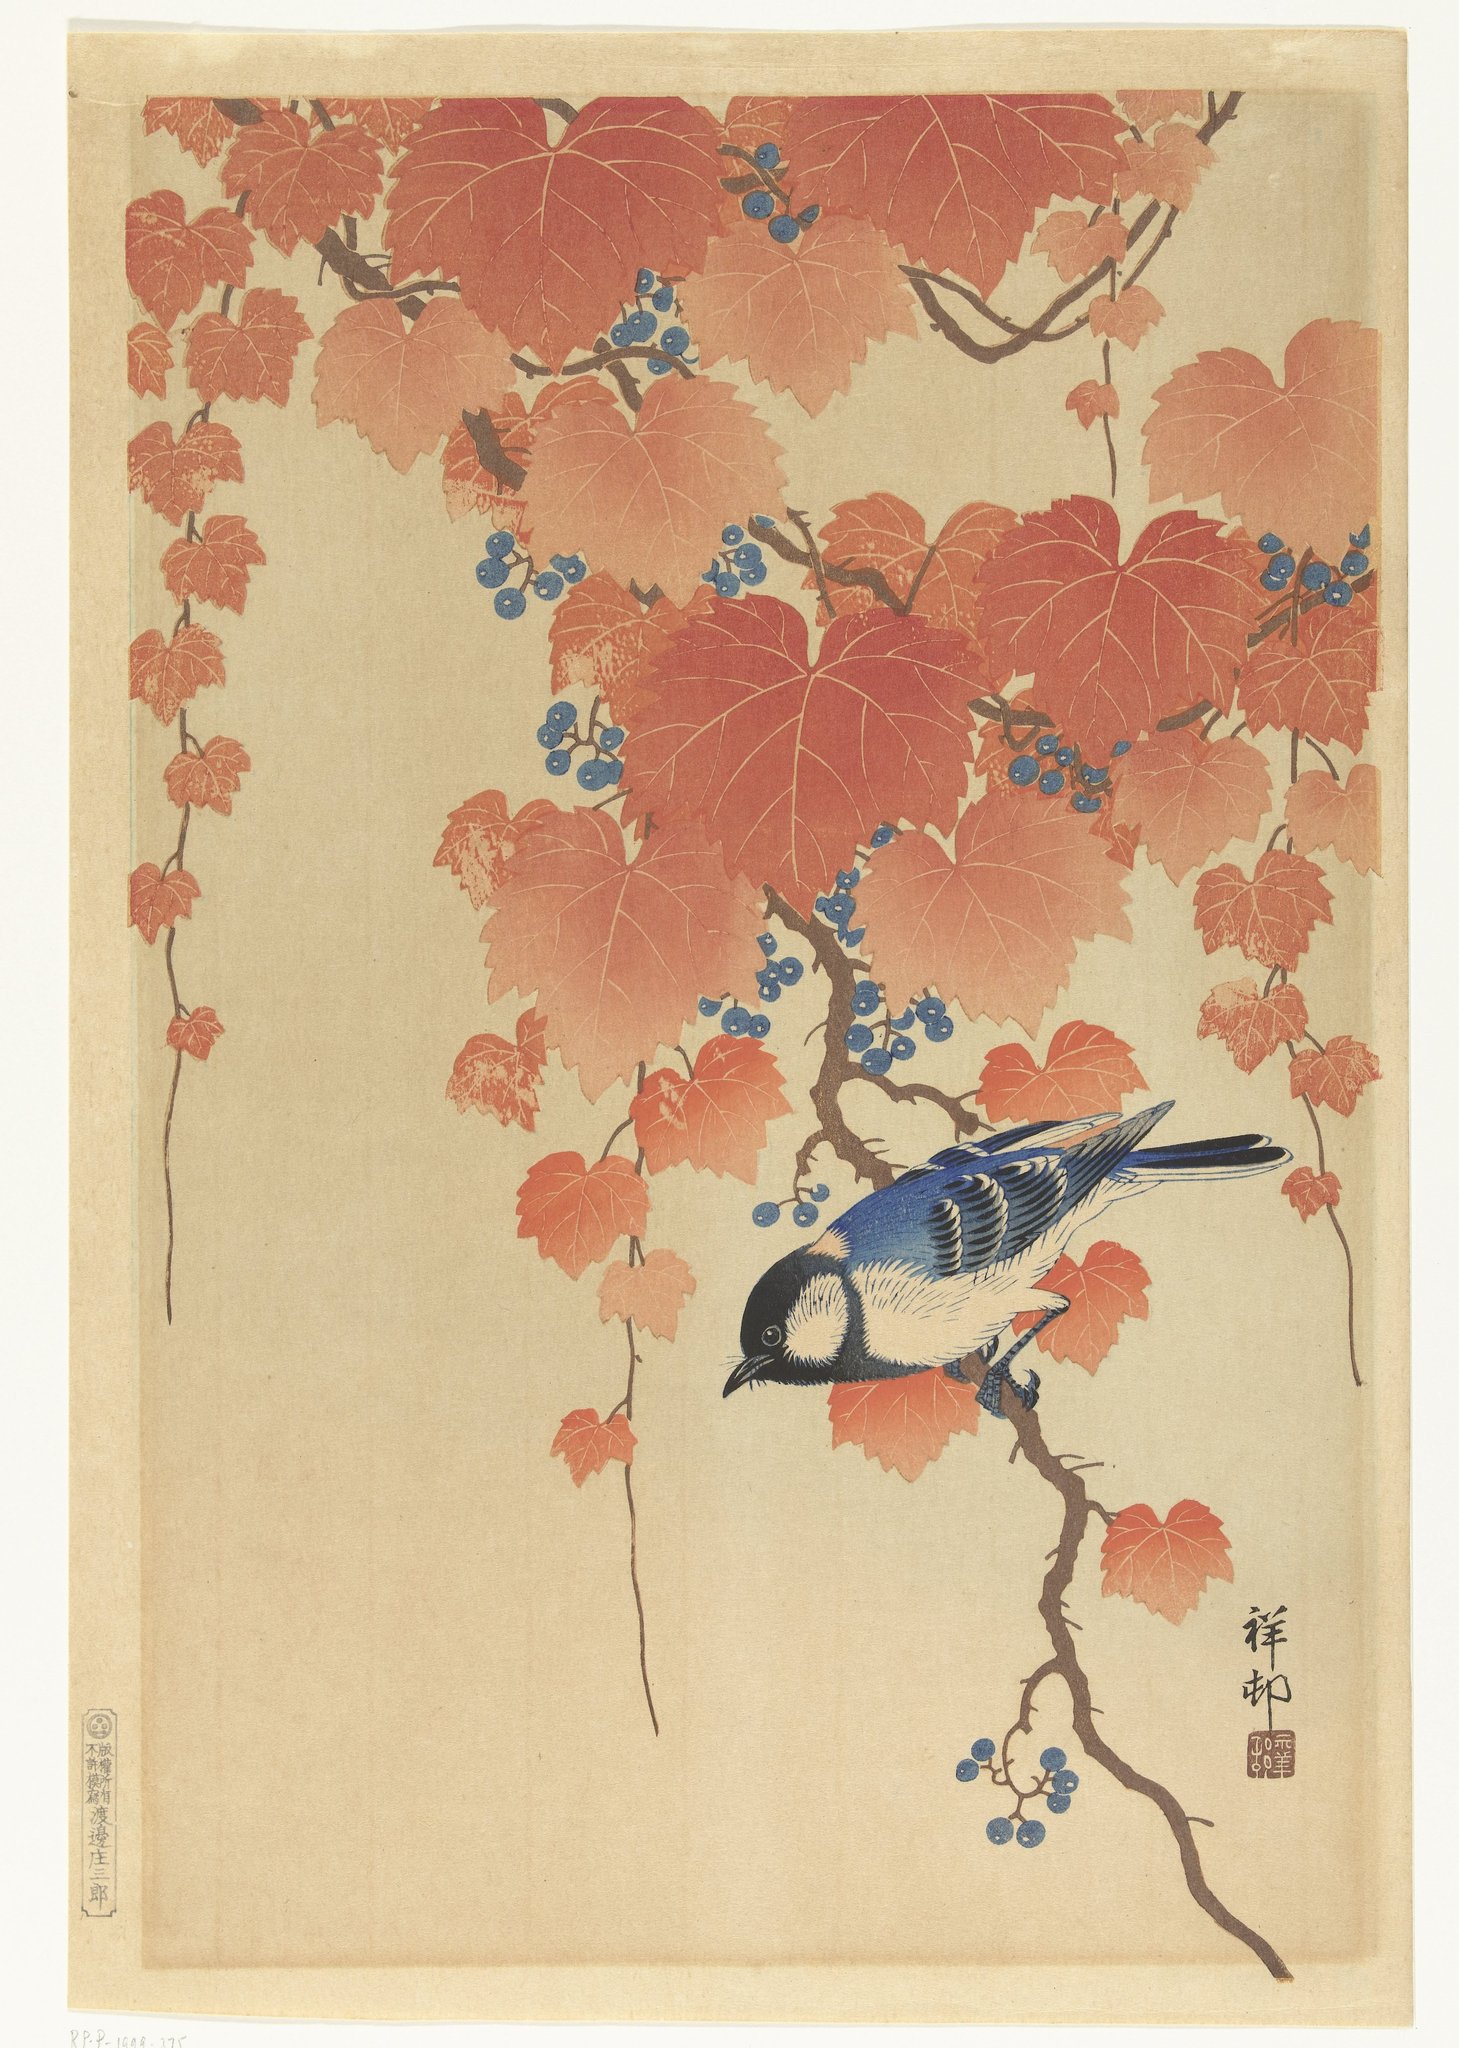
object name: print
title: Koolmees op paulownia tak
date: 1925-1936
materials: paper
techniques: woodcut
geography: tokyo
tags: plants; vegetation, birds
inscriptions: collector's mark: Lugt 2228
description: Koolmees op tak met oranje bladeren en blauwe besjes.